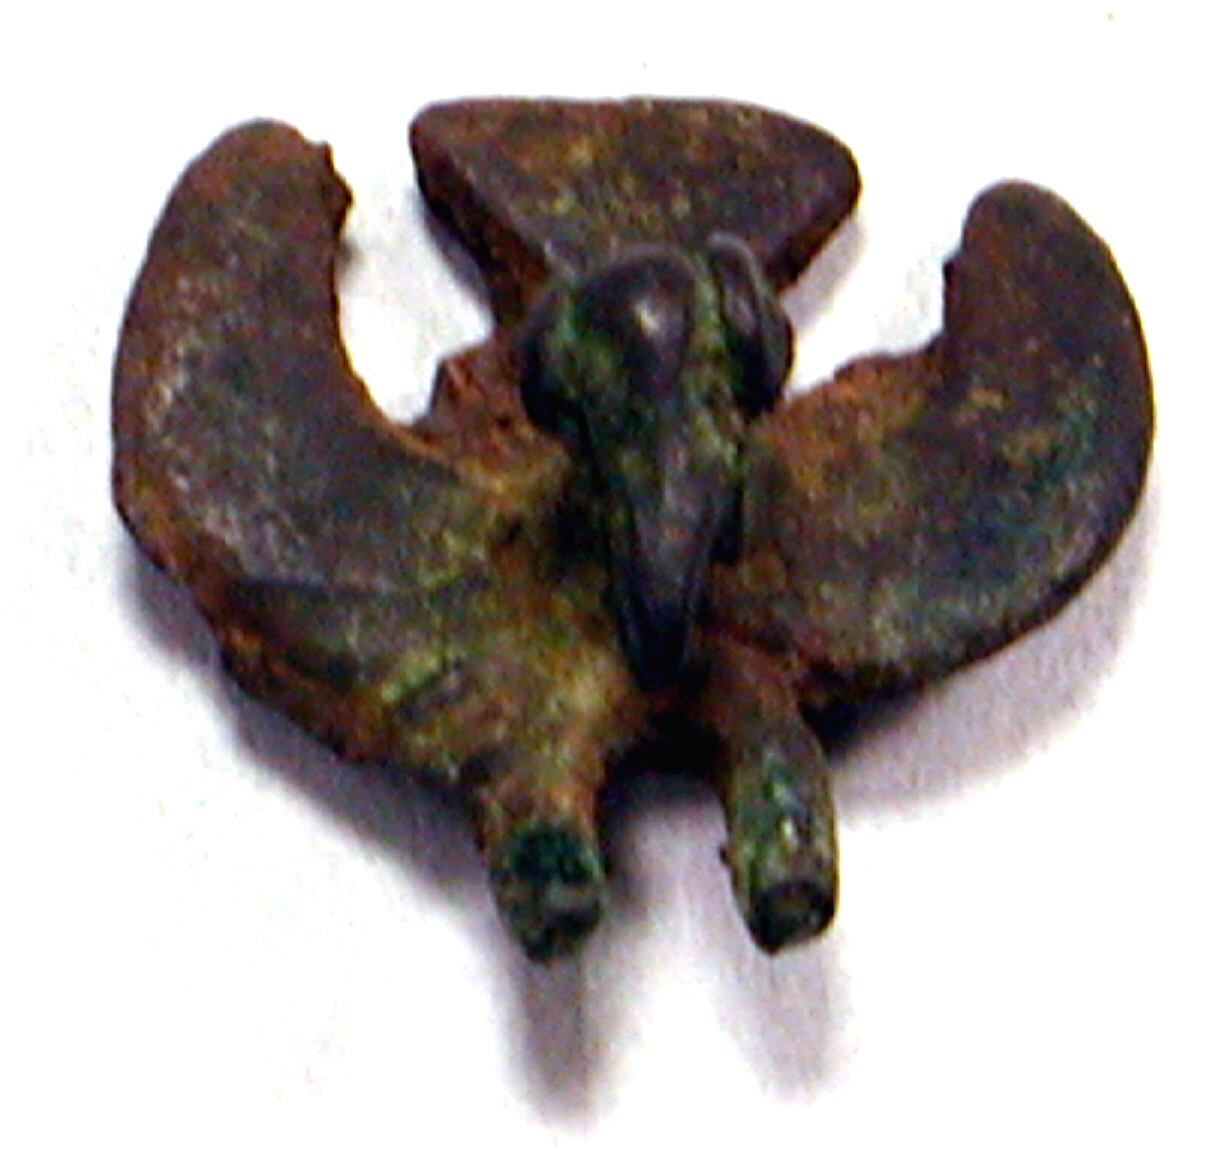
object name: fragment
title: Copper Bird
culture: peruvian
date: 1401-1500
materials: copper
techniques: casting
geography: peru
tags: birds